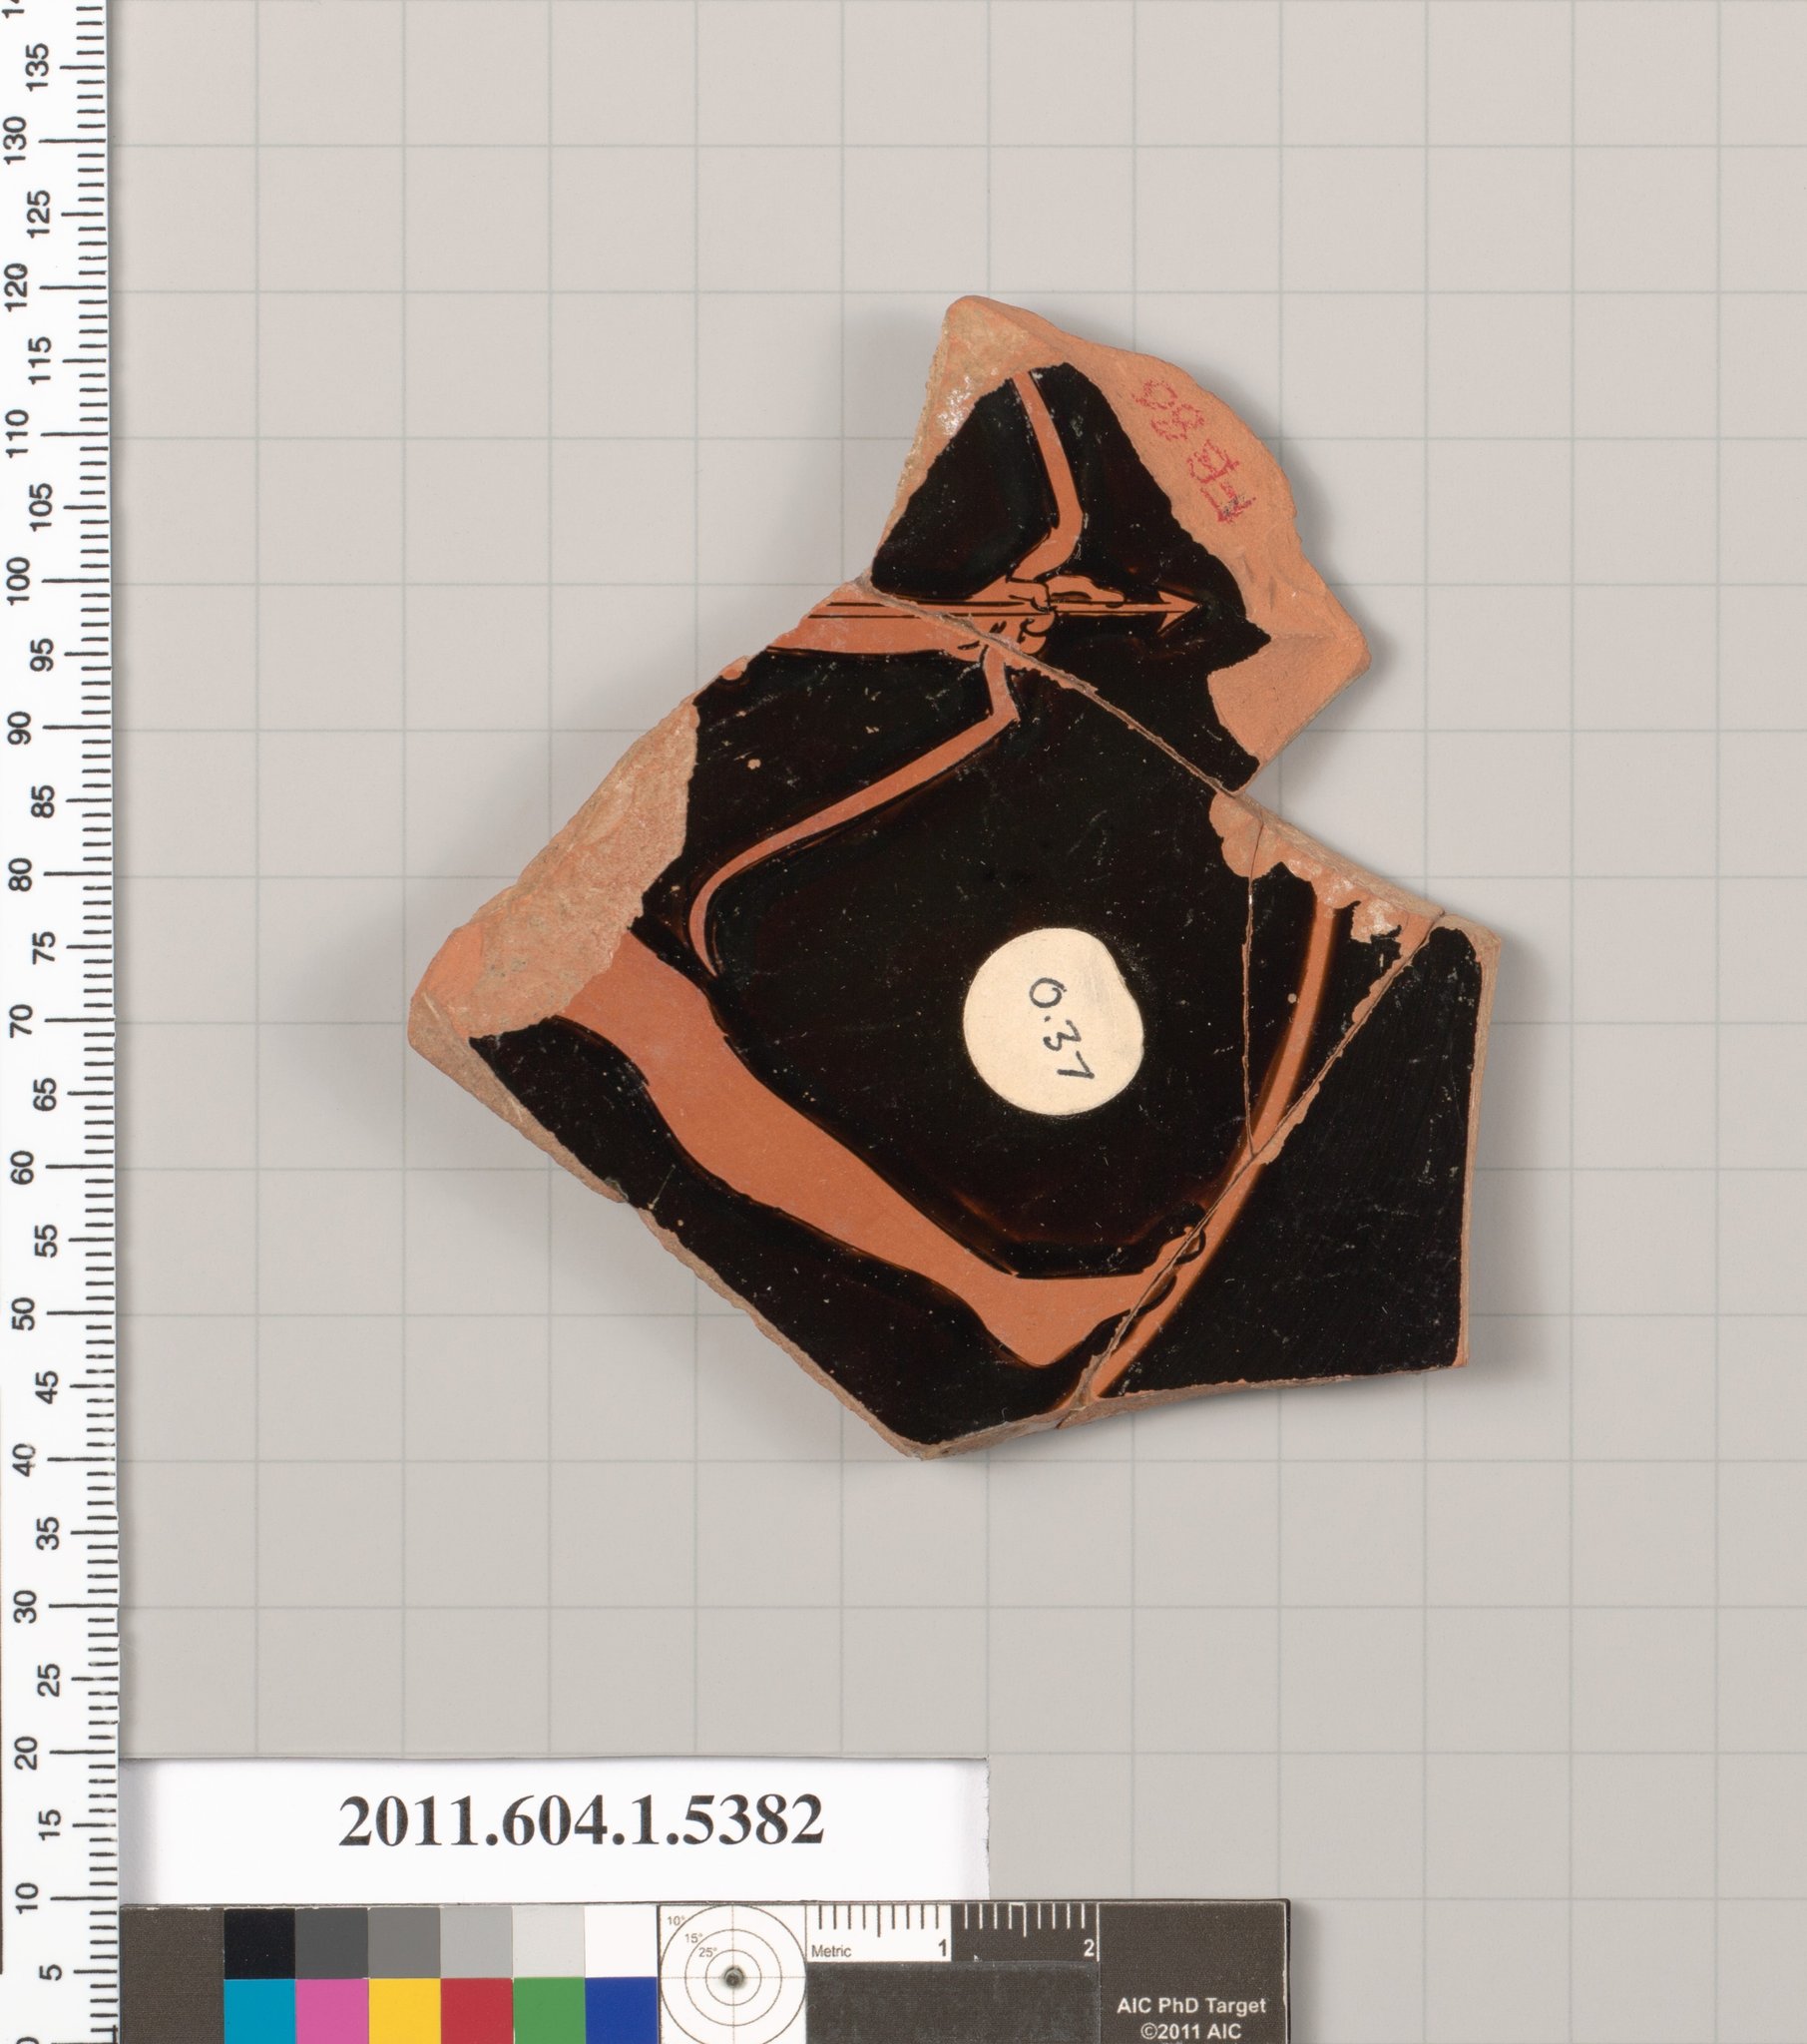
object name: kylix fragment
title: Terracotta fragment of a kylix (drinking cup)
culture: greek, attic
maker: apollodoros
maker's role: artist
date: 500-490 BCE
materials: terracotta